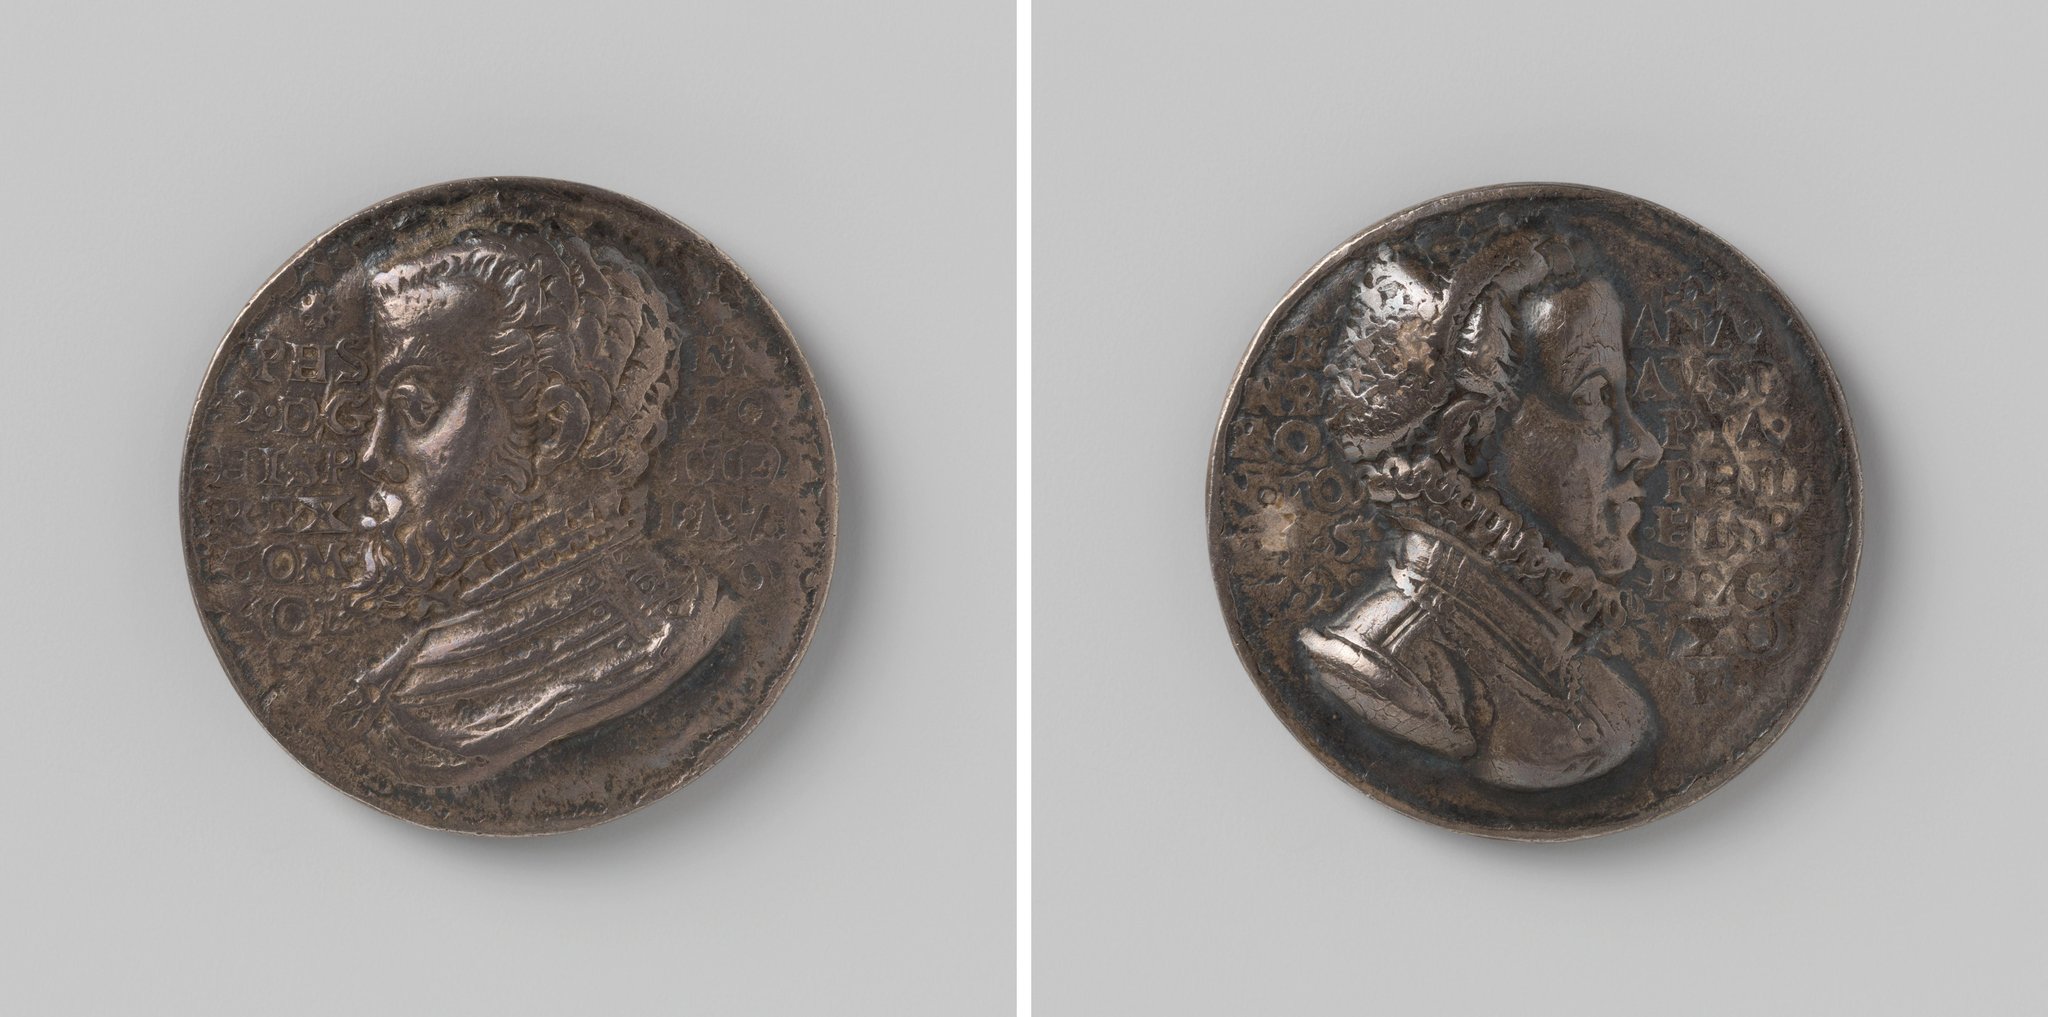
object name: history medal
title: Trouw aan Filips II van Spanje en Anna van Oosterijk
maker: Anonymous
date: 1572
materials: silver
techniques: casting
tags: philip ii of spain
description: Zilveren penning. Voorzijde: borststuk man tussen opschrift. Keerzijde: borststuk vrouw tussen opschrift.